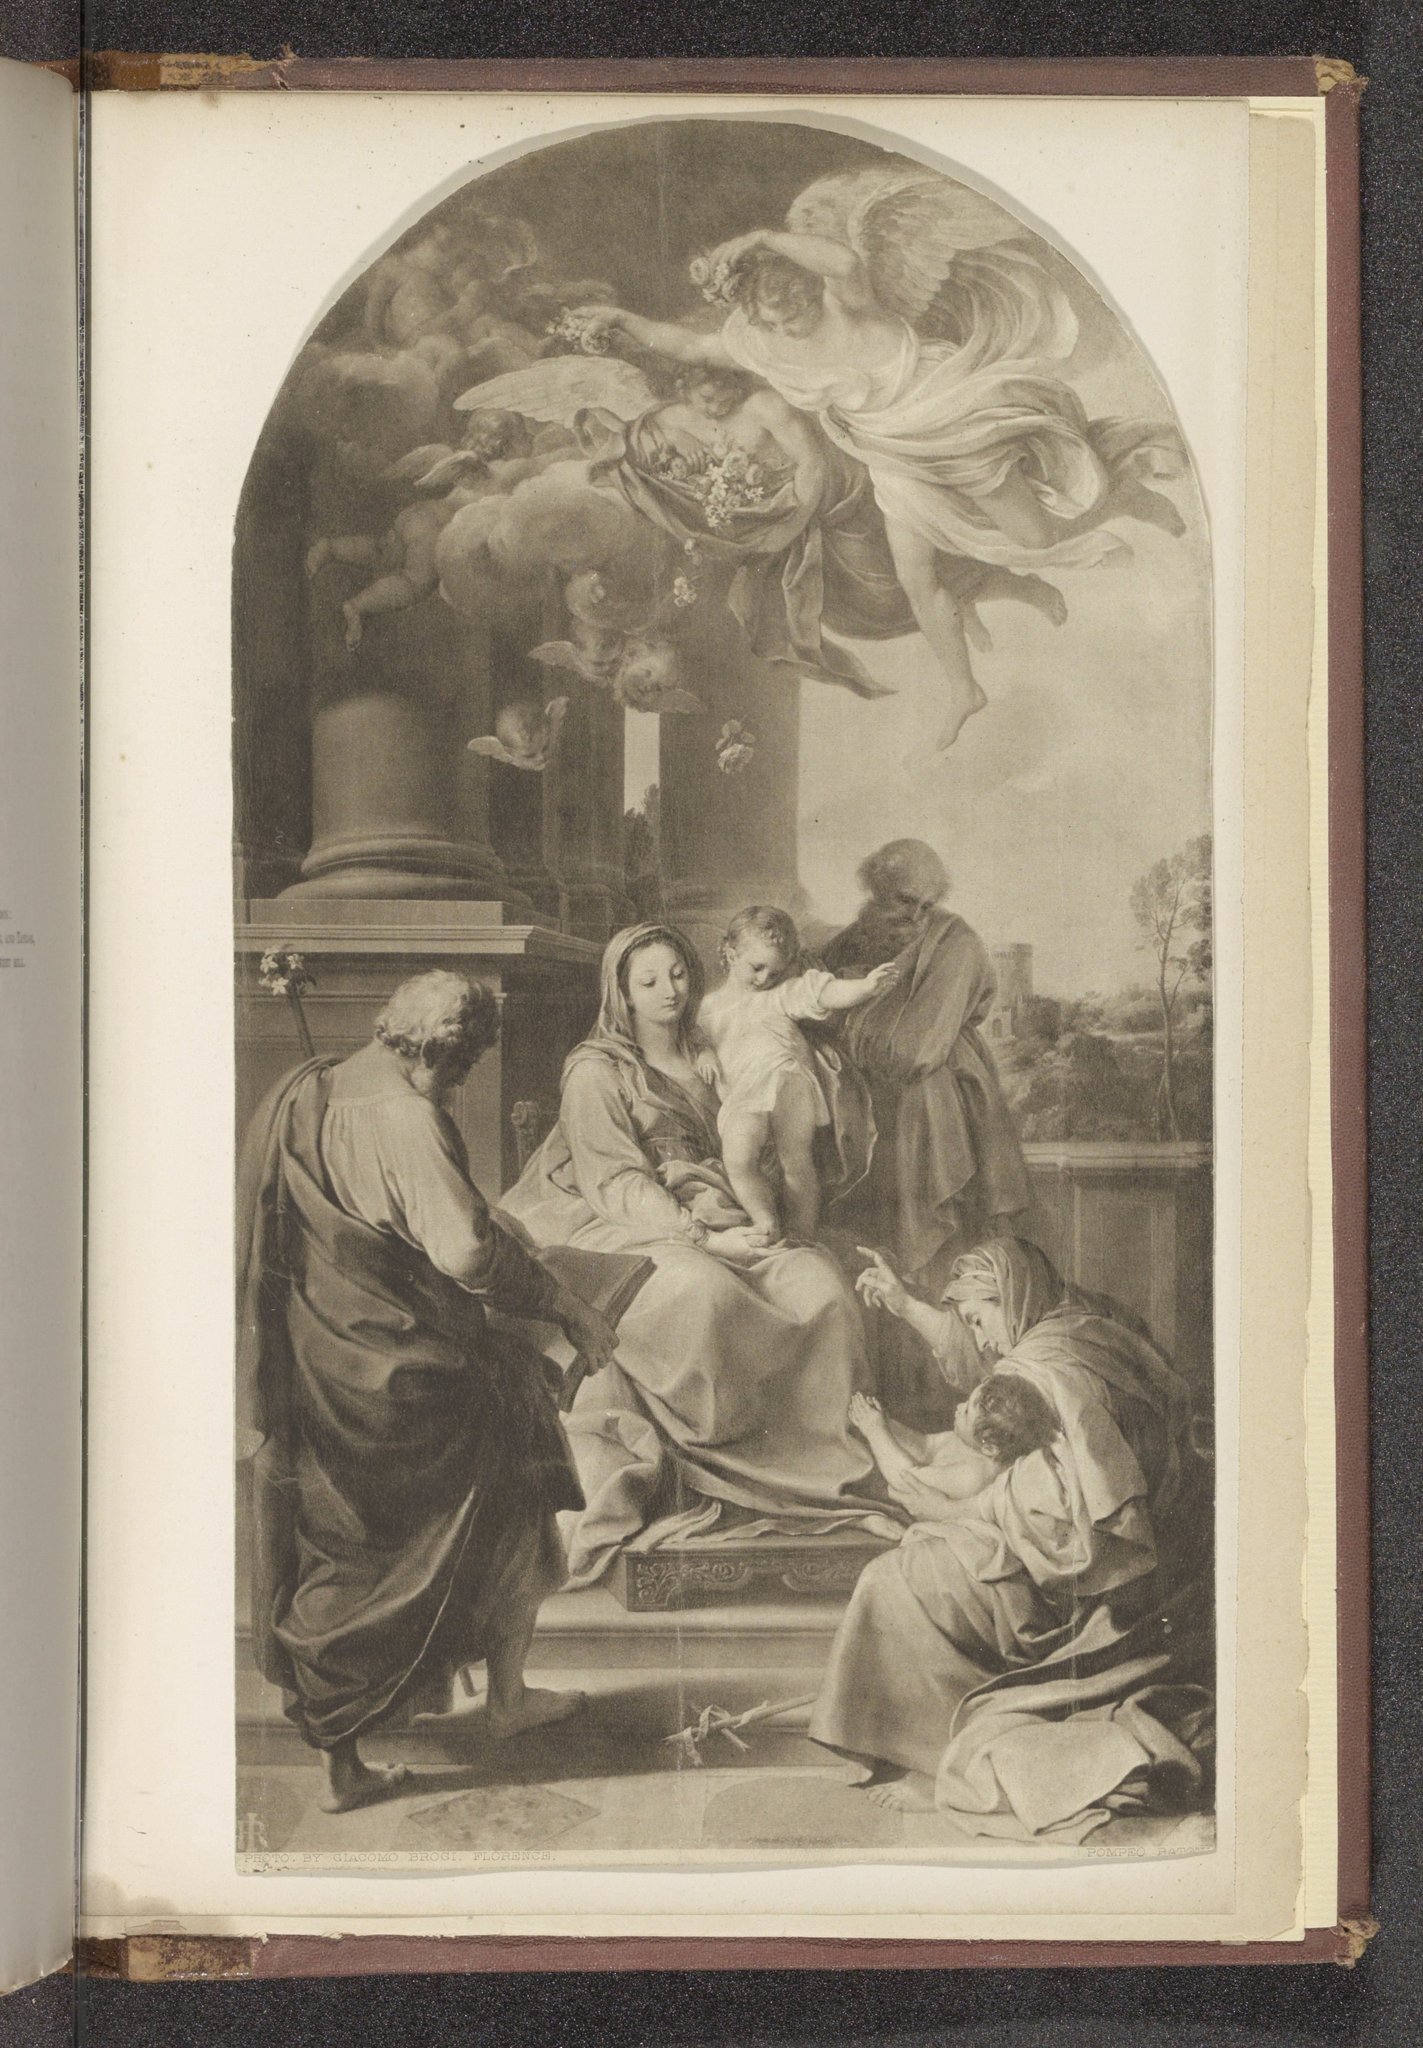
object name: reproduction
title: Fotoreproductie van een schilderij, voorstellende Maria met Kind en heiligen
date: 1872-1882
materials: paper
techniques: rotogravure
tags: mary sitting on steps or a staircase ~ madonna-representations